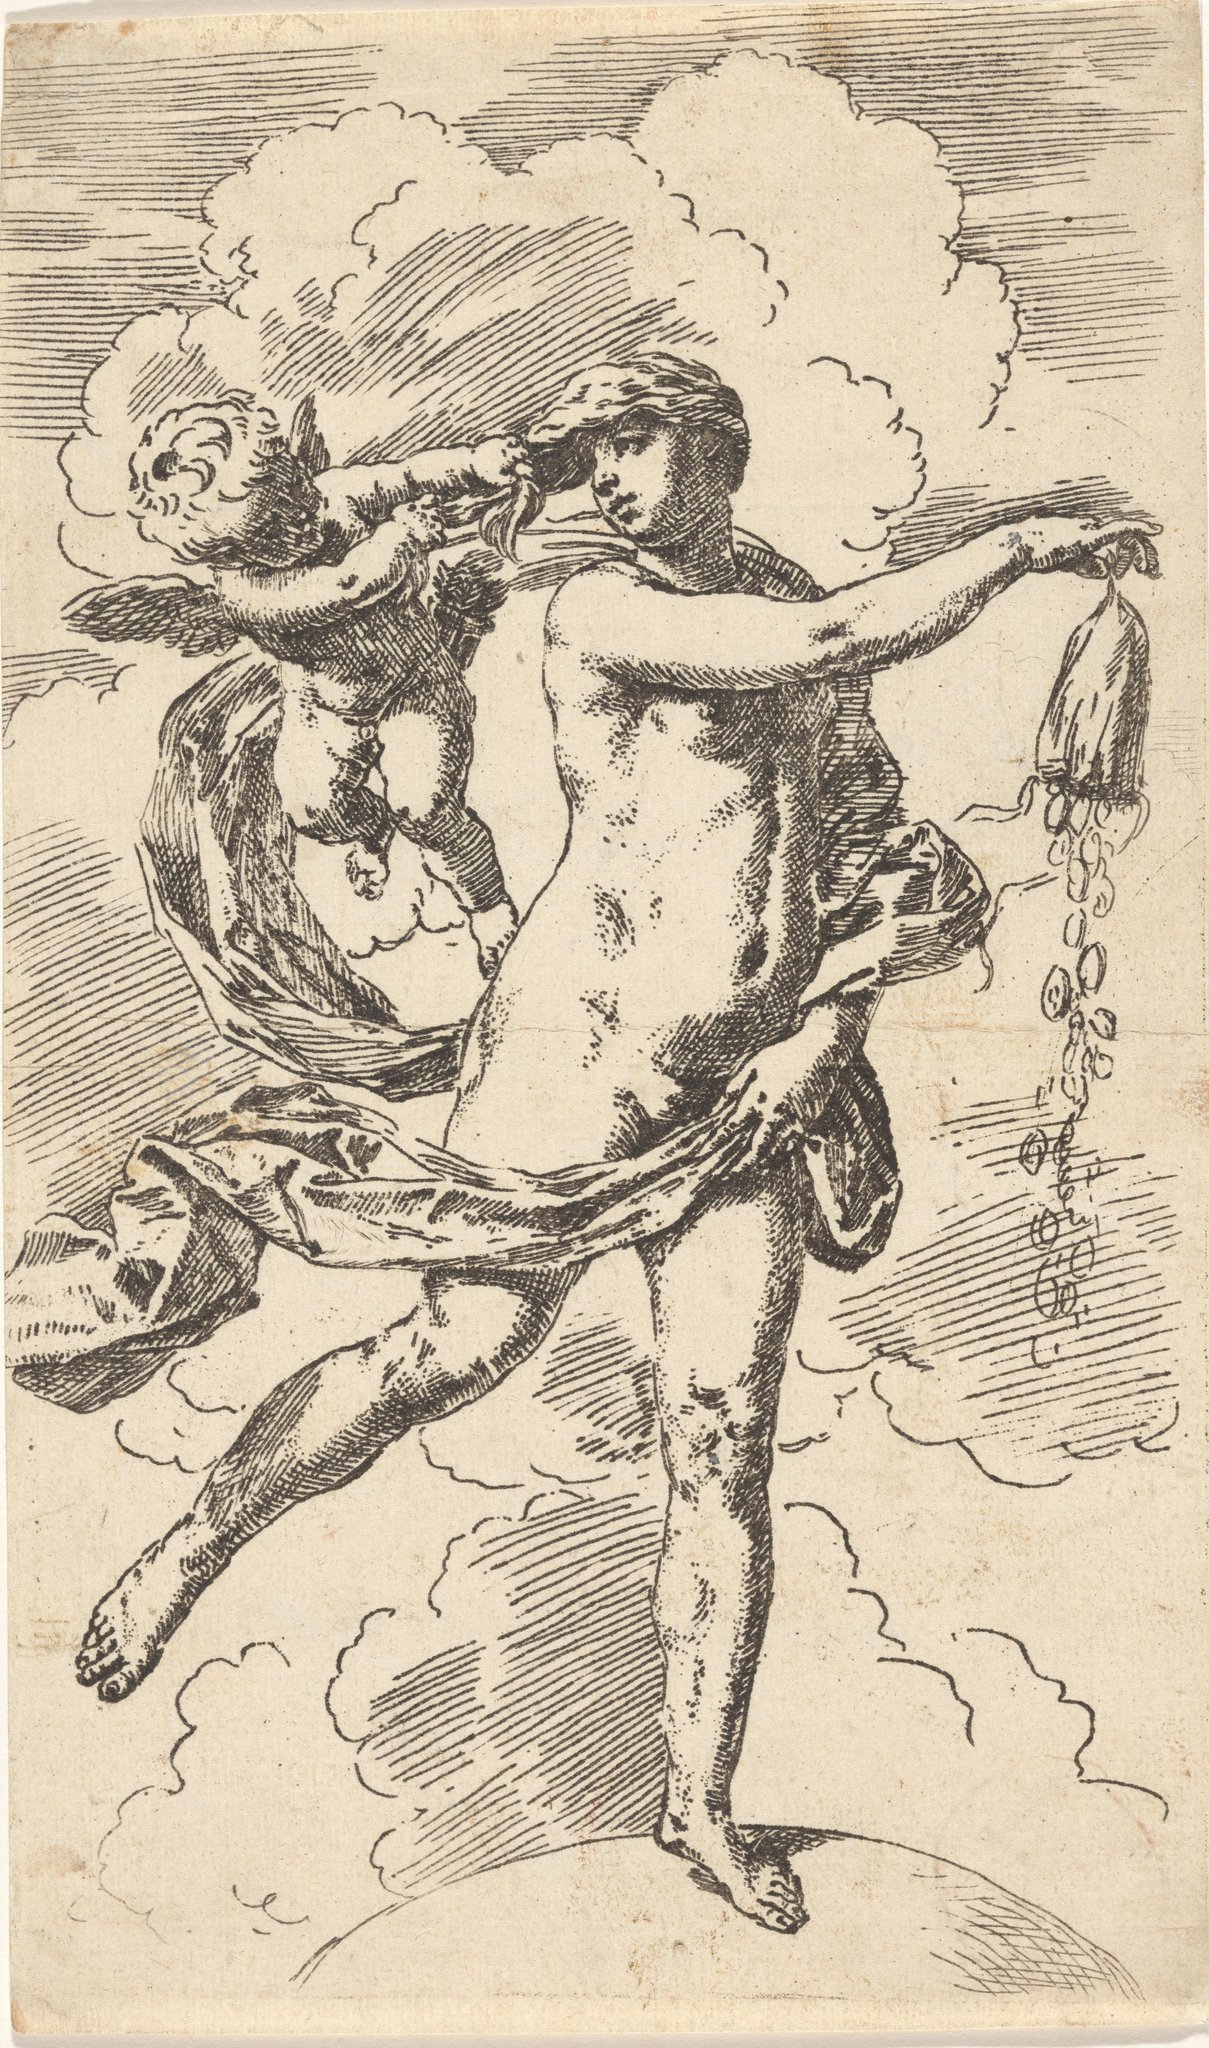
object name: print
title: Fortuna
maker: simone cantarini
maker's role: draughtsman, print maker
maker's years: 1612-1648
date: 1622-1648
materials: paper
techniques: printmaking, etching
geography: italy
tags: luck, fortune, lot; 'fato', 'fortuna', 'fortuna aurea', 'fortuna buona', 'fortuna pacifica overo clemente', 'sorte' (ripa)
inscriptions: collector's mark: Lugt 240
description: Fortuna staat op een globe. Ze kiept een zak met munten om. Een putto trekt aan haar haren.